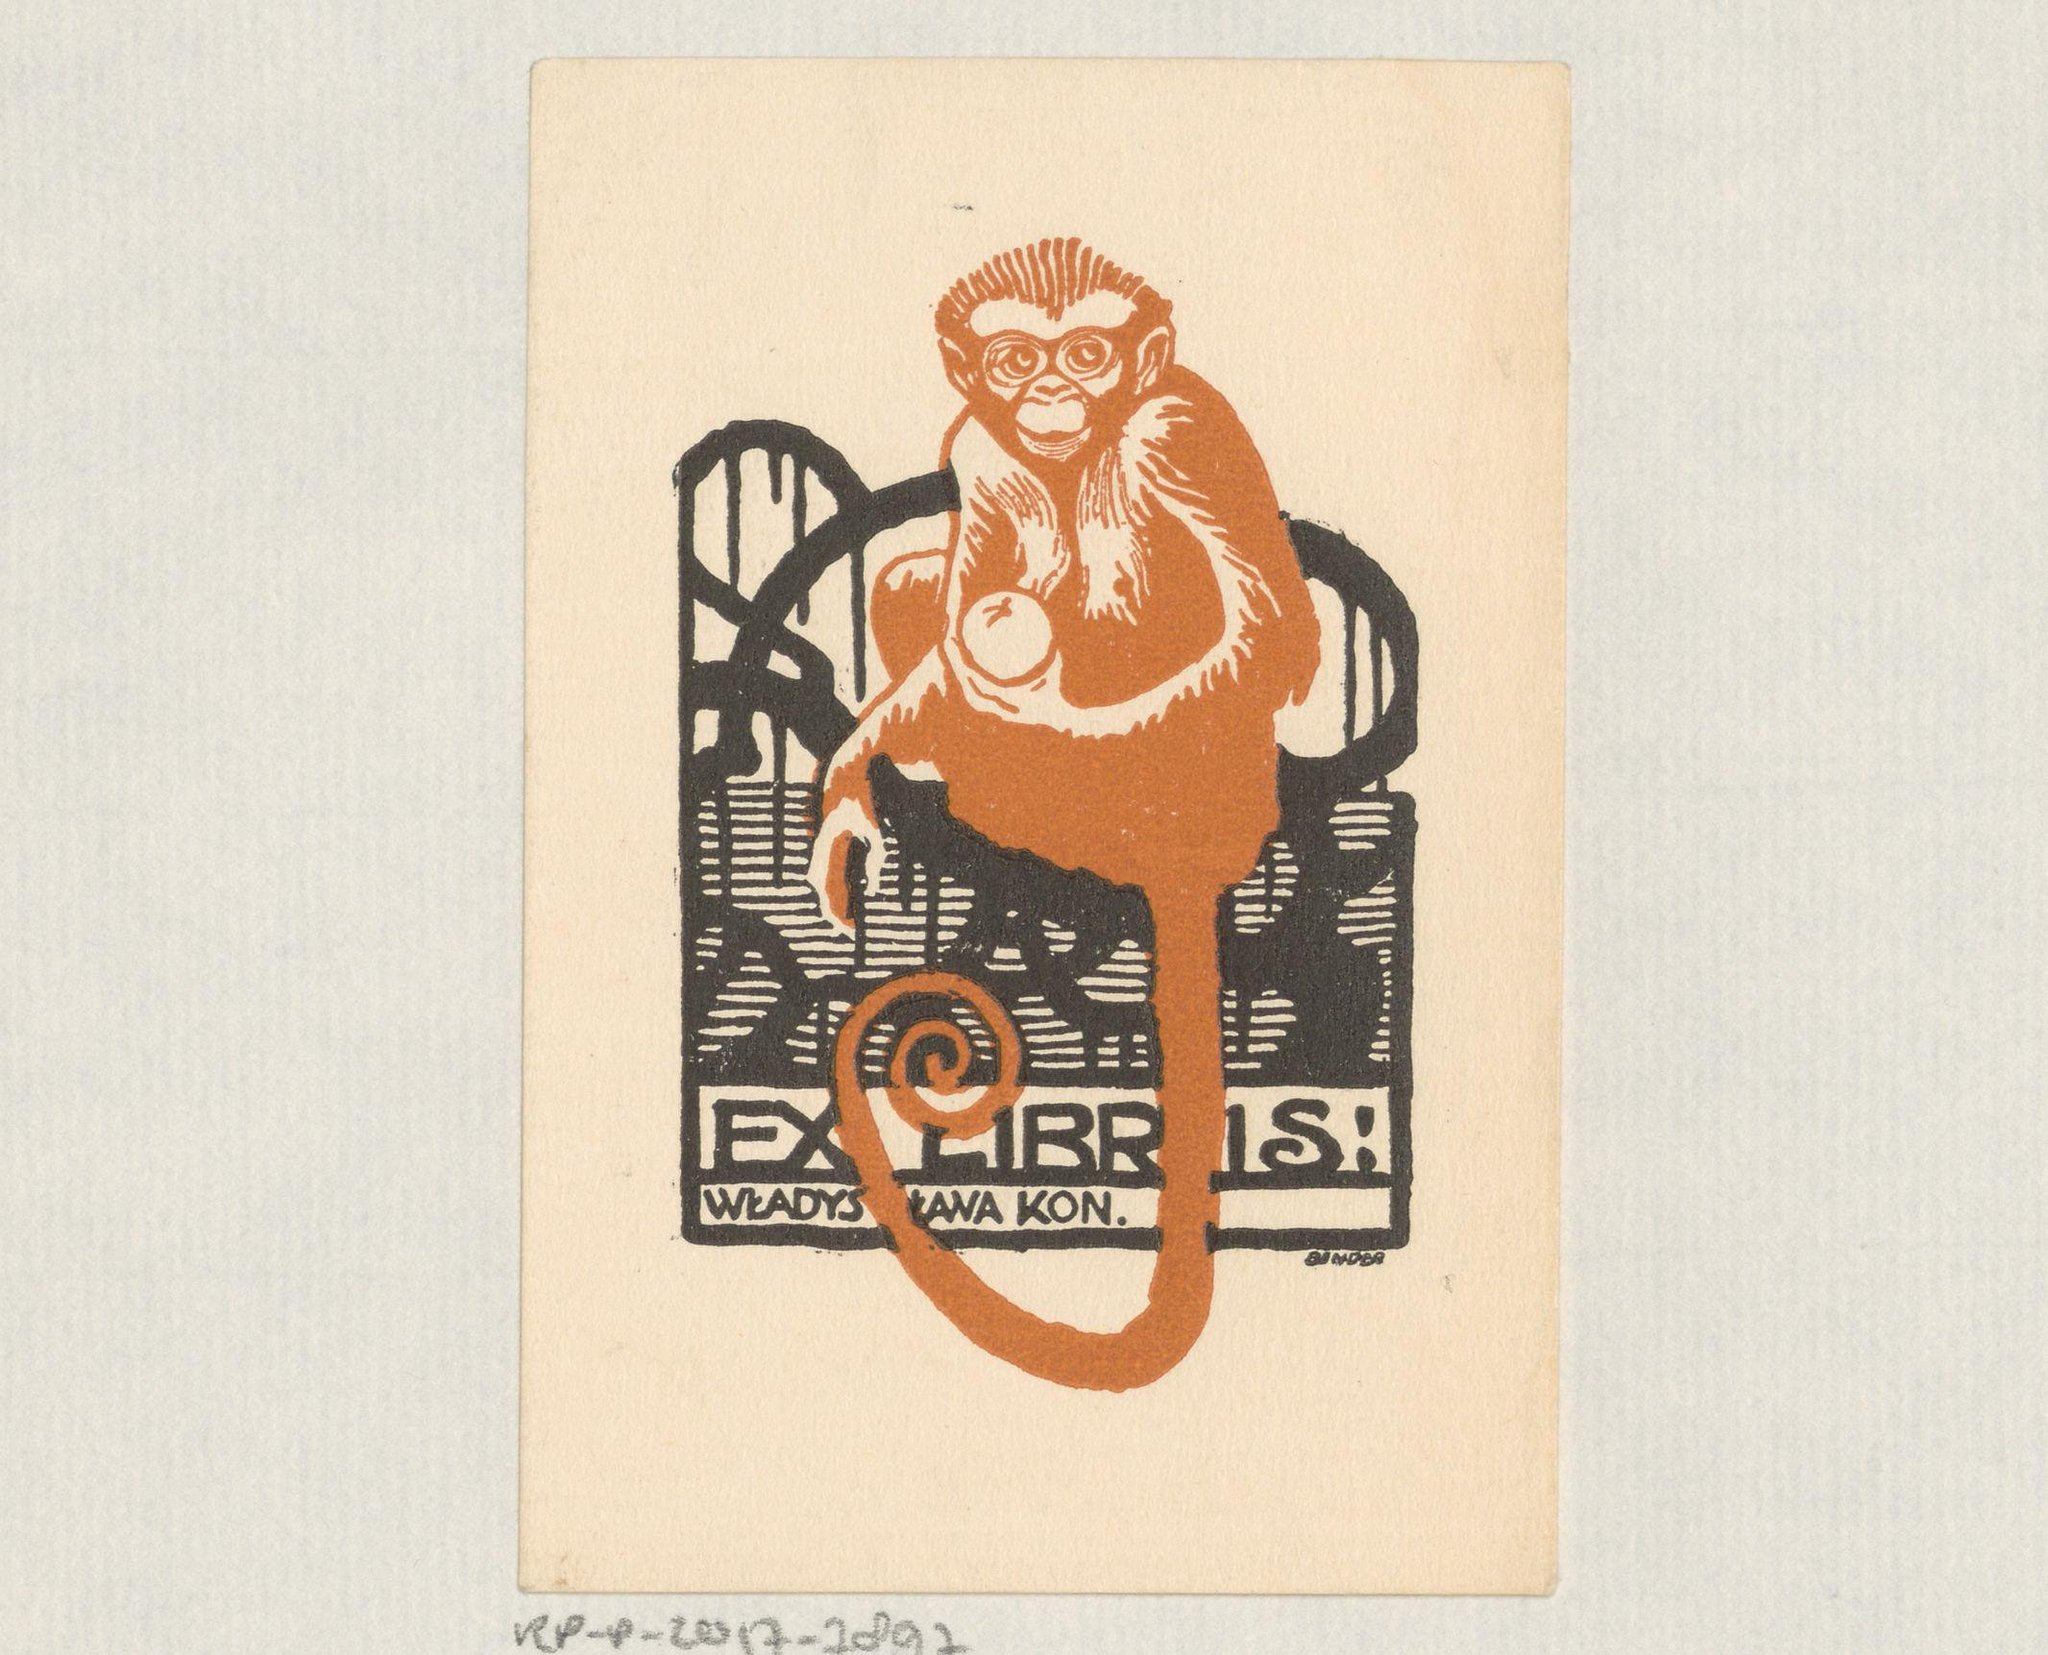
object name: bookplate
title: Ex libris van Władysłava Kon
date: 1900-1999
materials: paper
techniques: printing block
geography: poland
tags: monkeys, apes